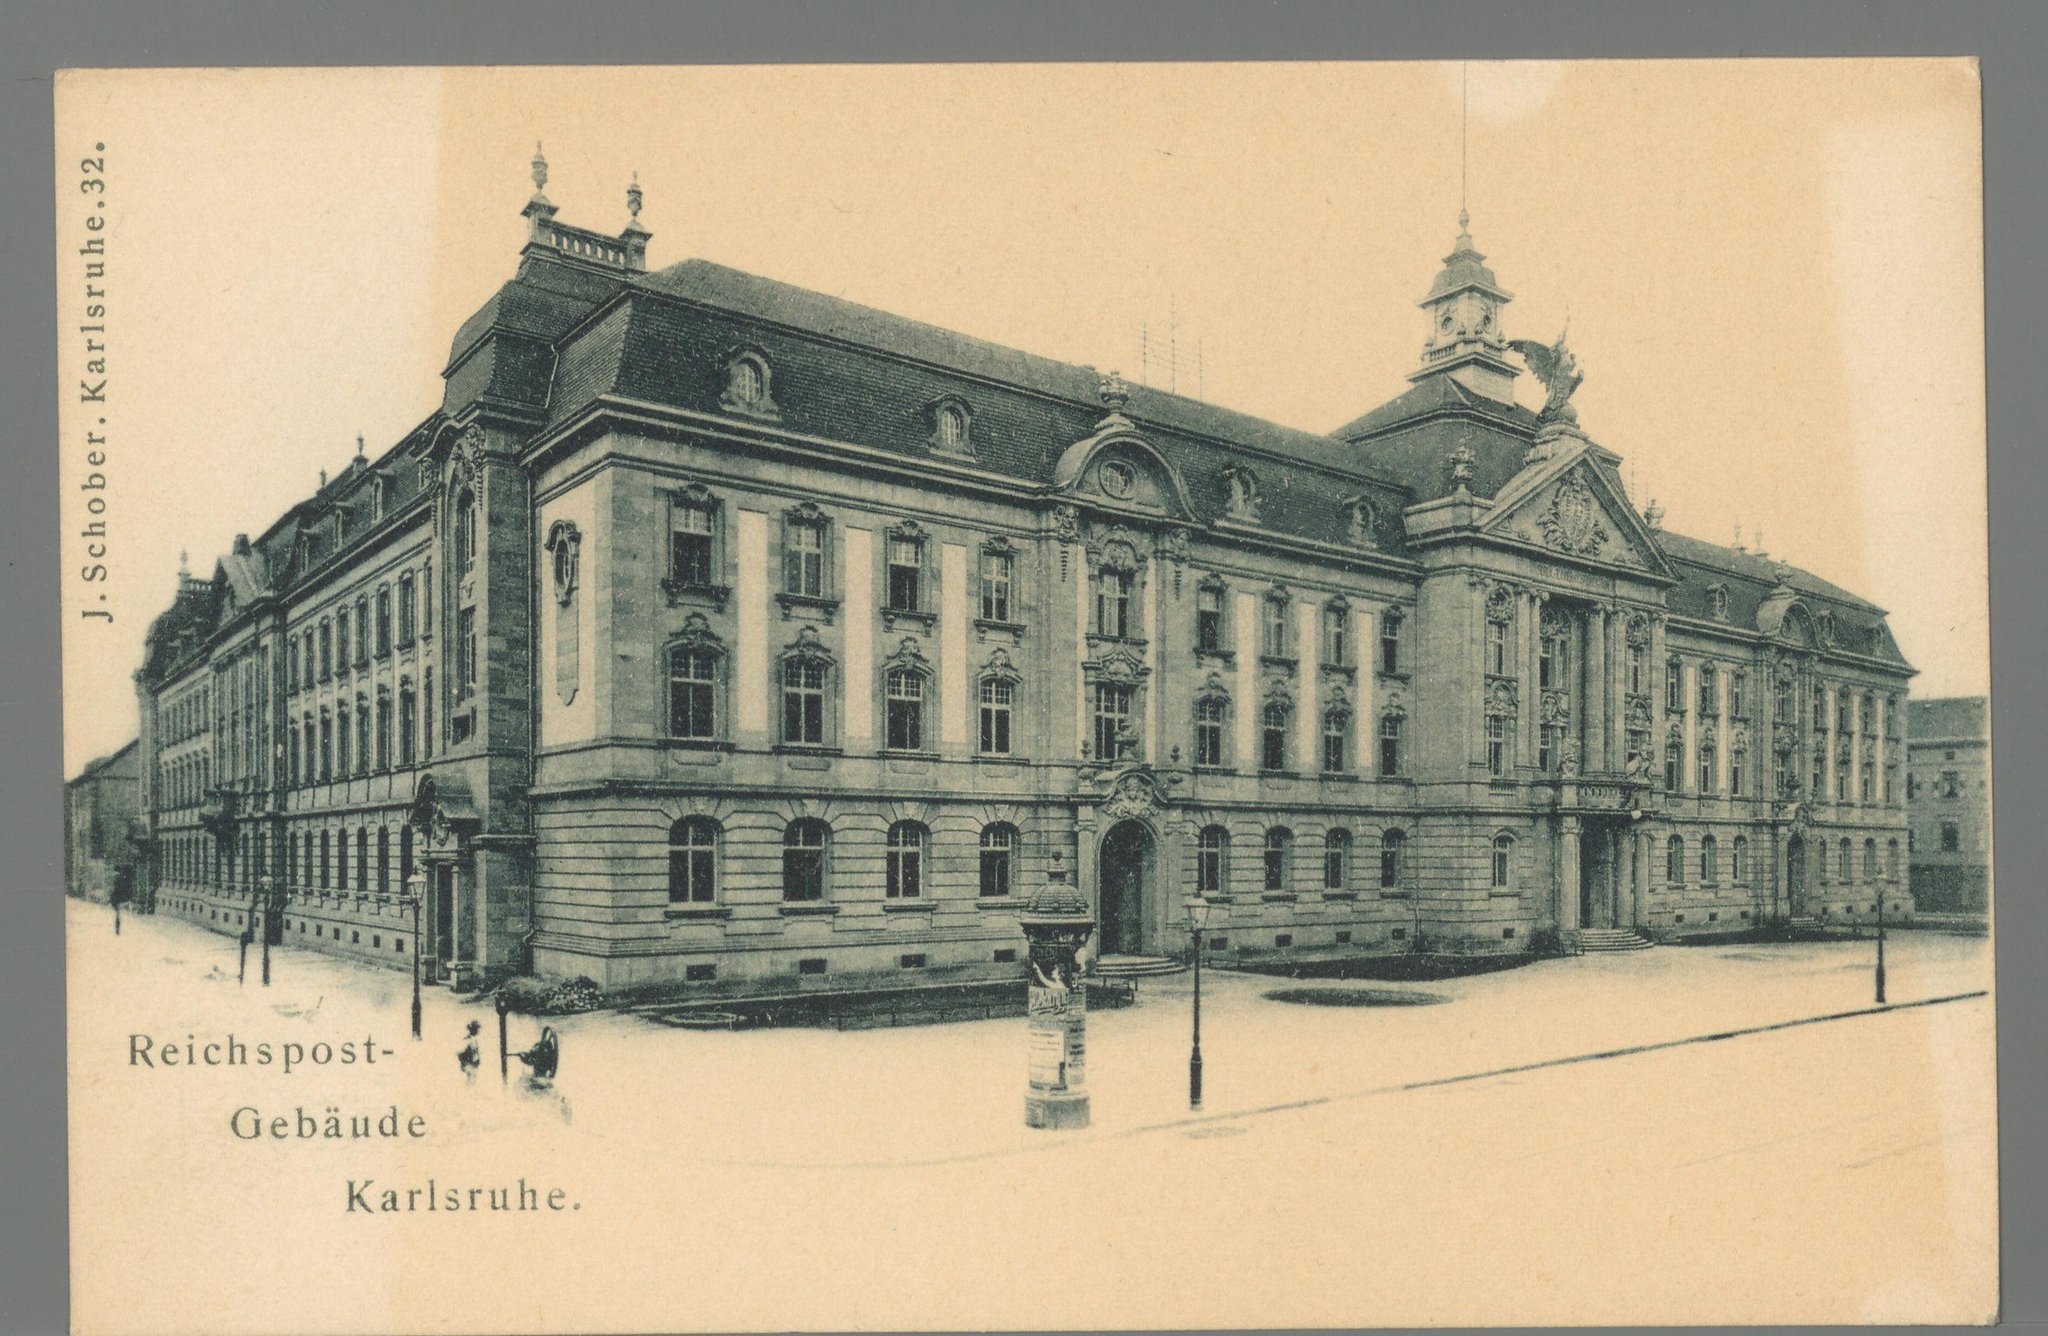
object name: photomechanical print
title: Reichspost-Gebäude Karlsruhe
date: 1885-1905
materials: cardboard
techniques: photograph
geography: karlsruhe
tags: post-office